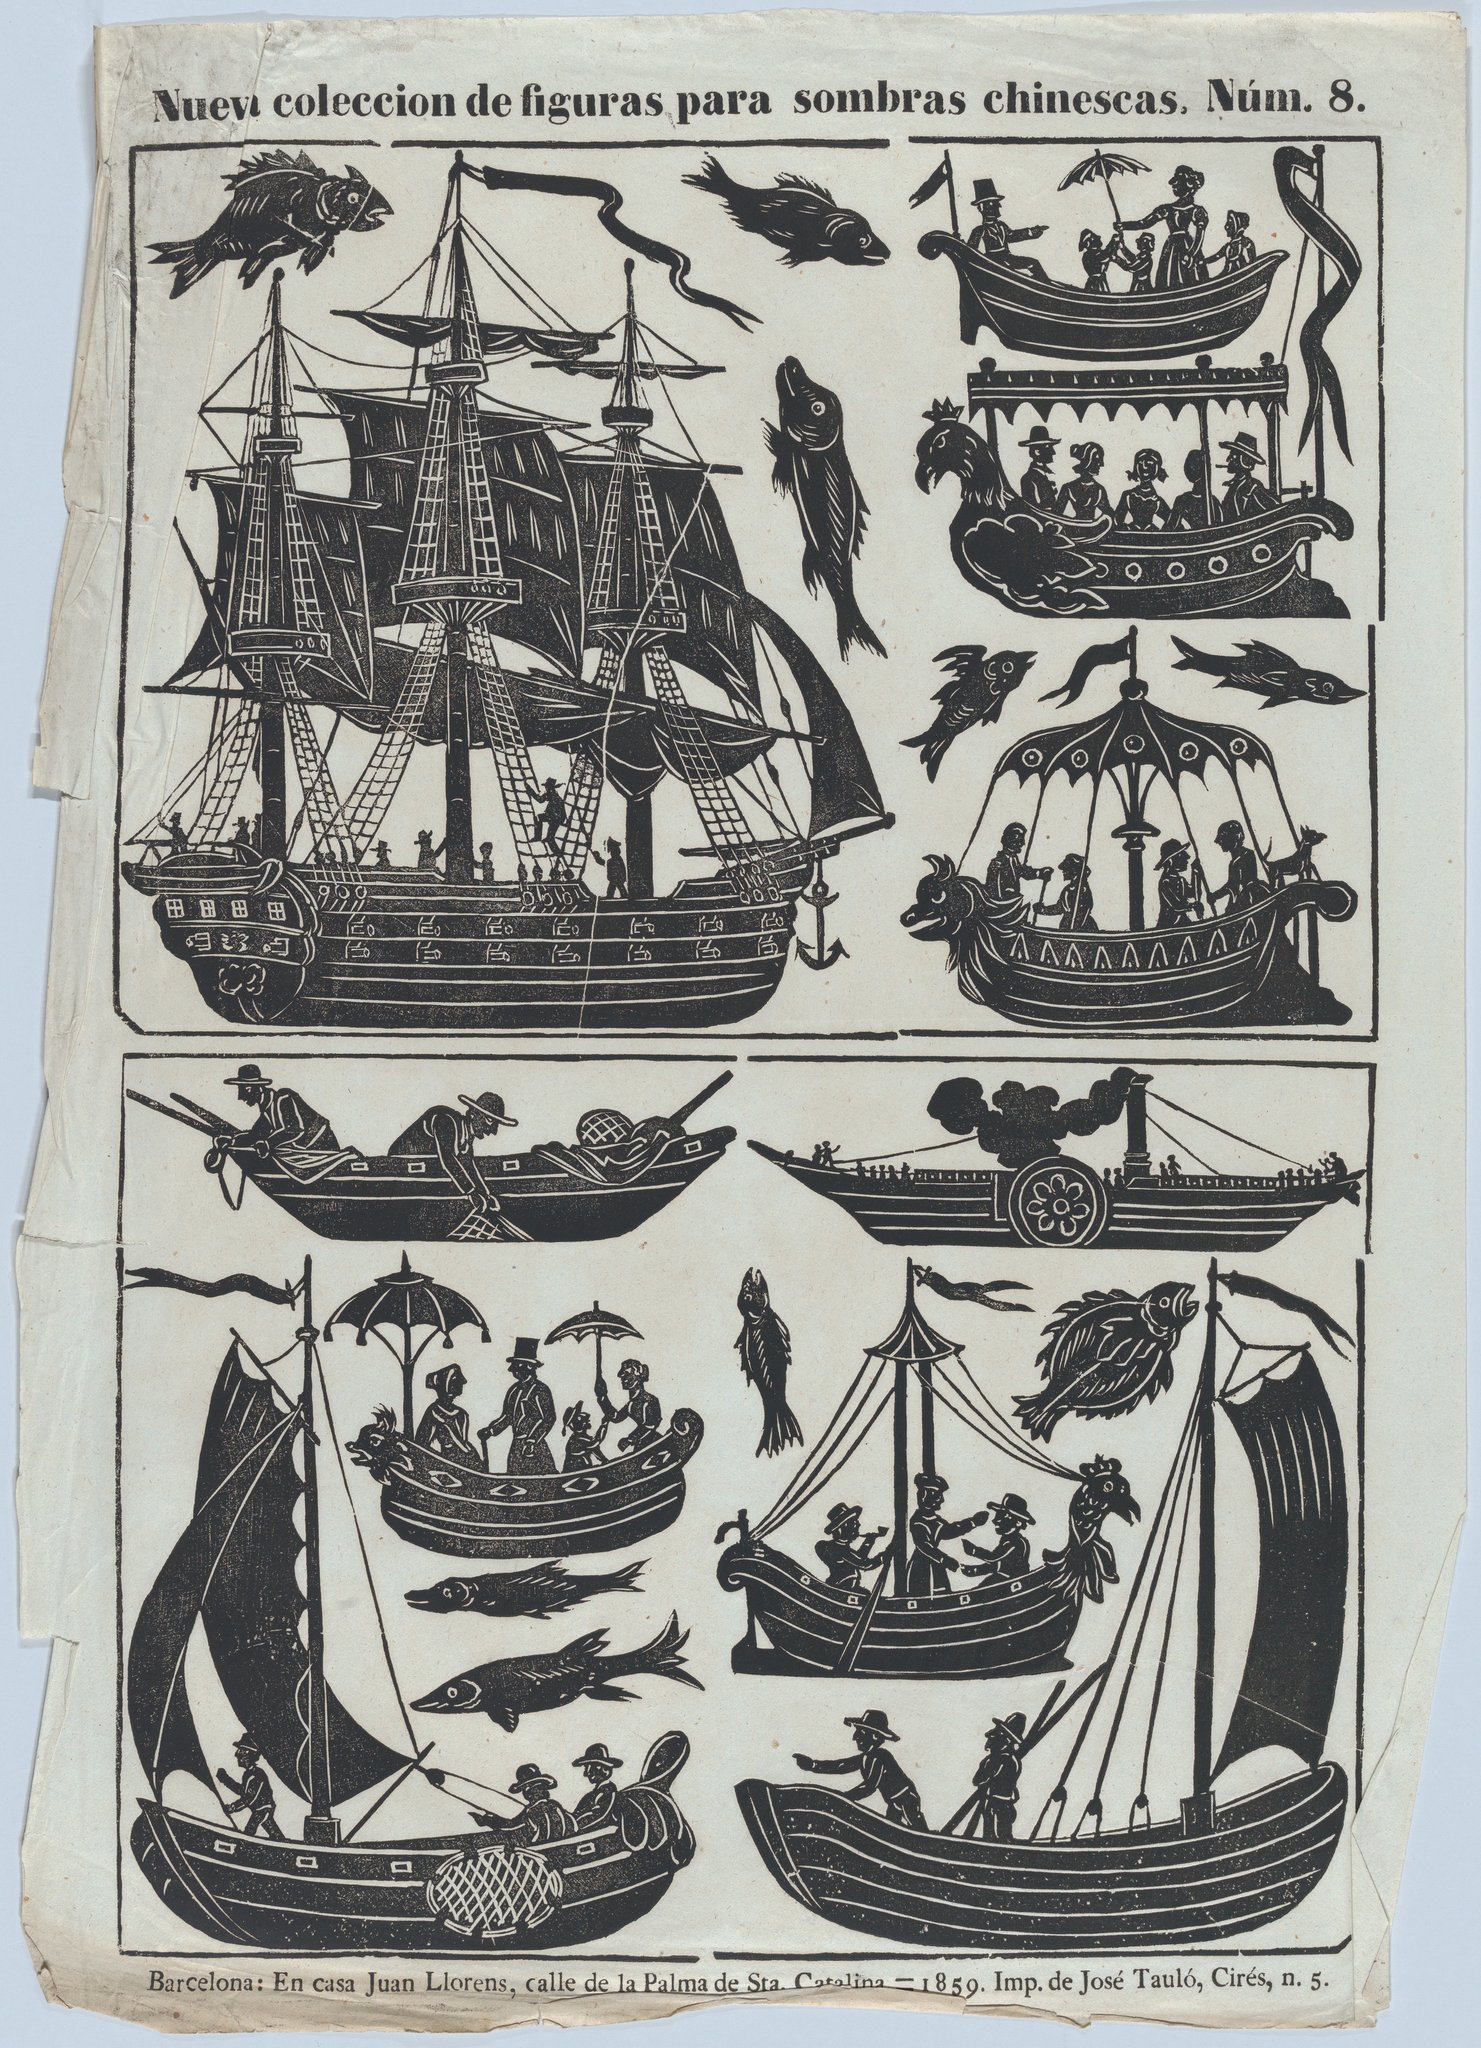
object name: print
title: Sheet 8 of figures for Chinese shadow puppets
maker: juan llorens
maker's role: publisher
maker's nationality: spanish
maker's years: 1800-1900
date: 1859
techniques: engraving, woodcut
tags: fish,boats,ships,puppets